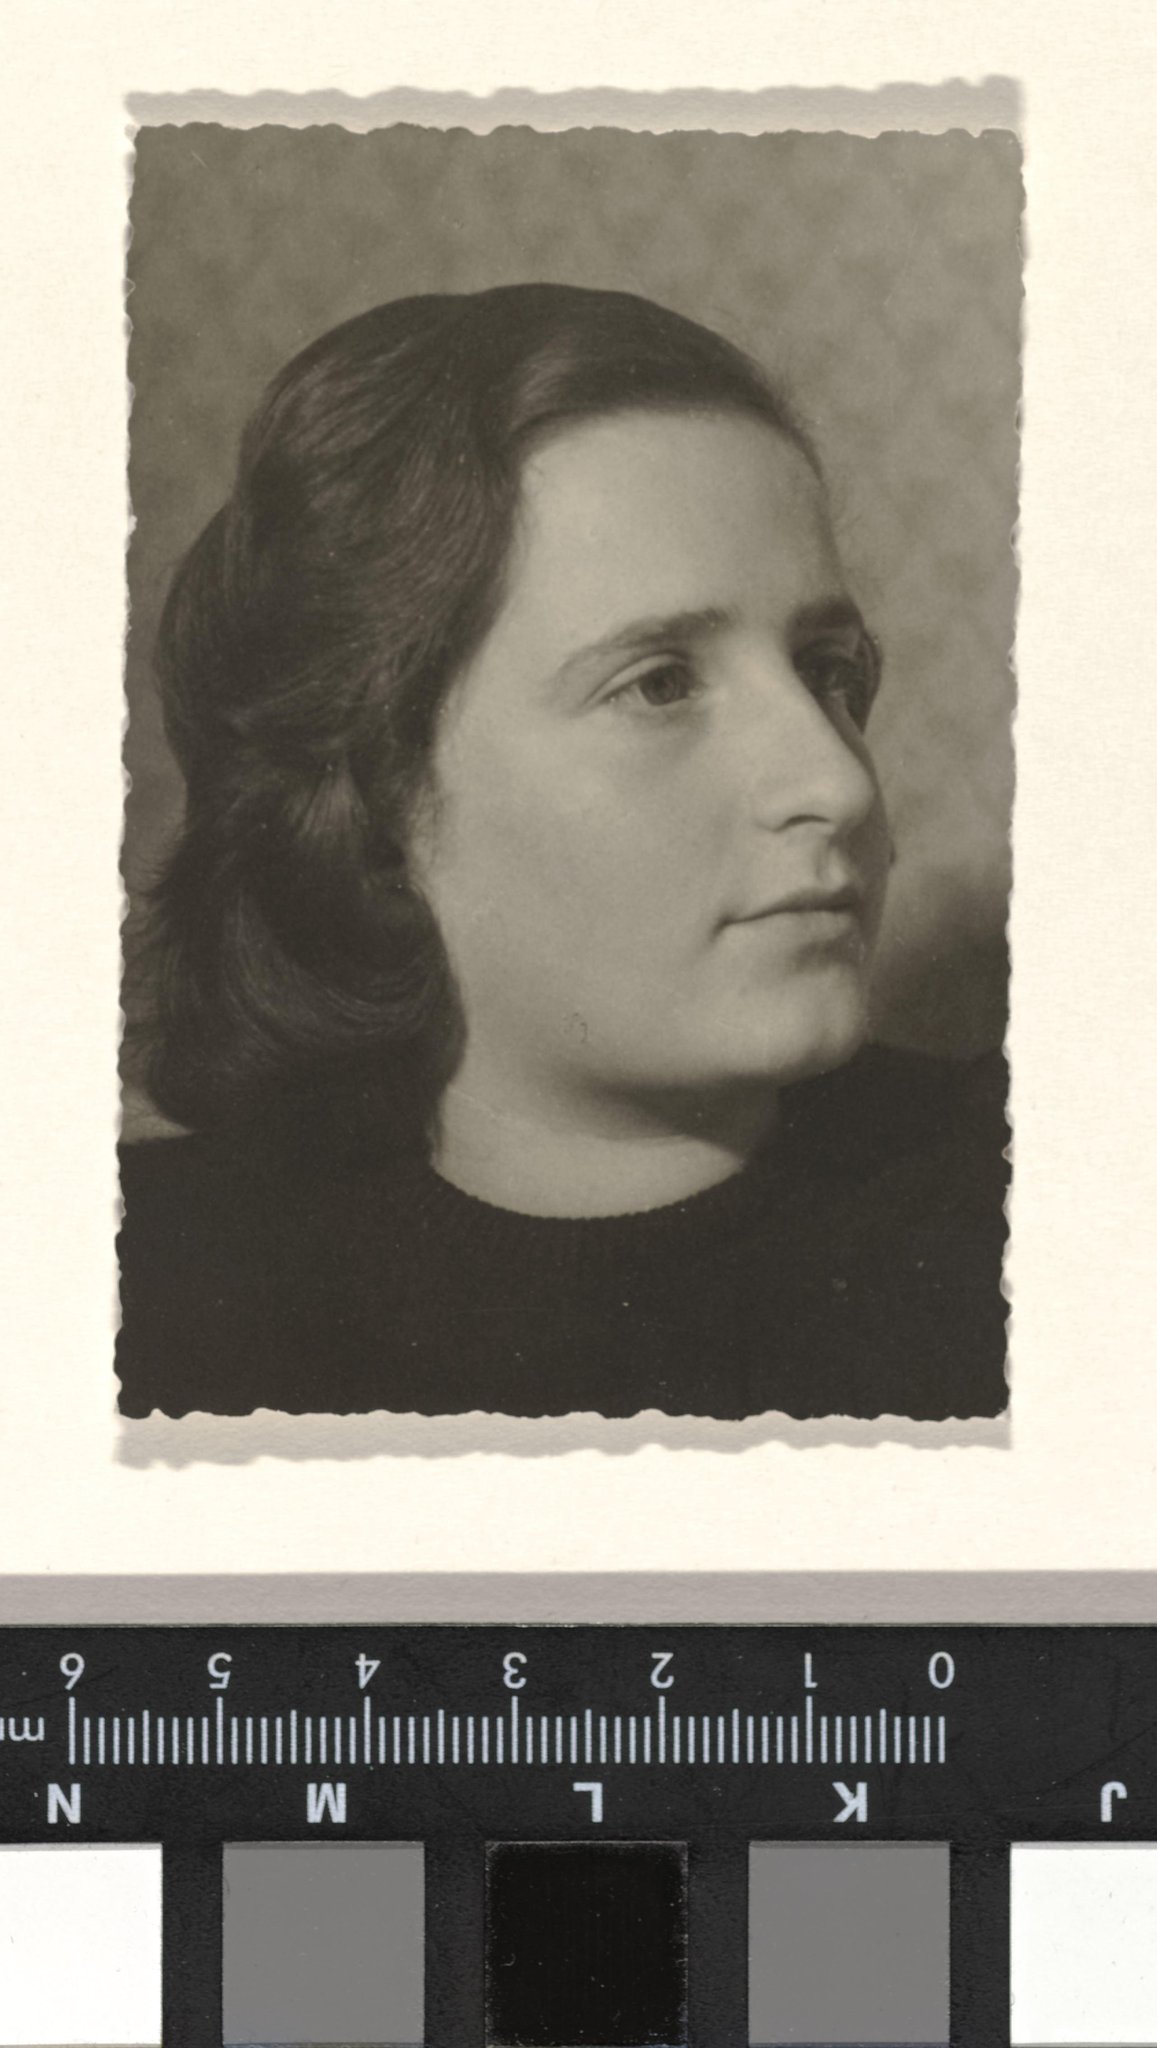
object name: photograph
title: Portret van Isabel Wachenheimer, bedoeld als eerste tekenen van leven aan een onbekende afzender, 25 september 1945 in Davos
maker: Anonymous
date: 1945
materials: photographic support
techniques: gelatin silver print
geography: davos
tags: leiden, isabel wachenheimer-elon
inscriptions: inscription: ‘Vergesst nicht eure alte Isabel (Hebreeuwse tekst) 25.9.1945.’